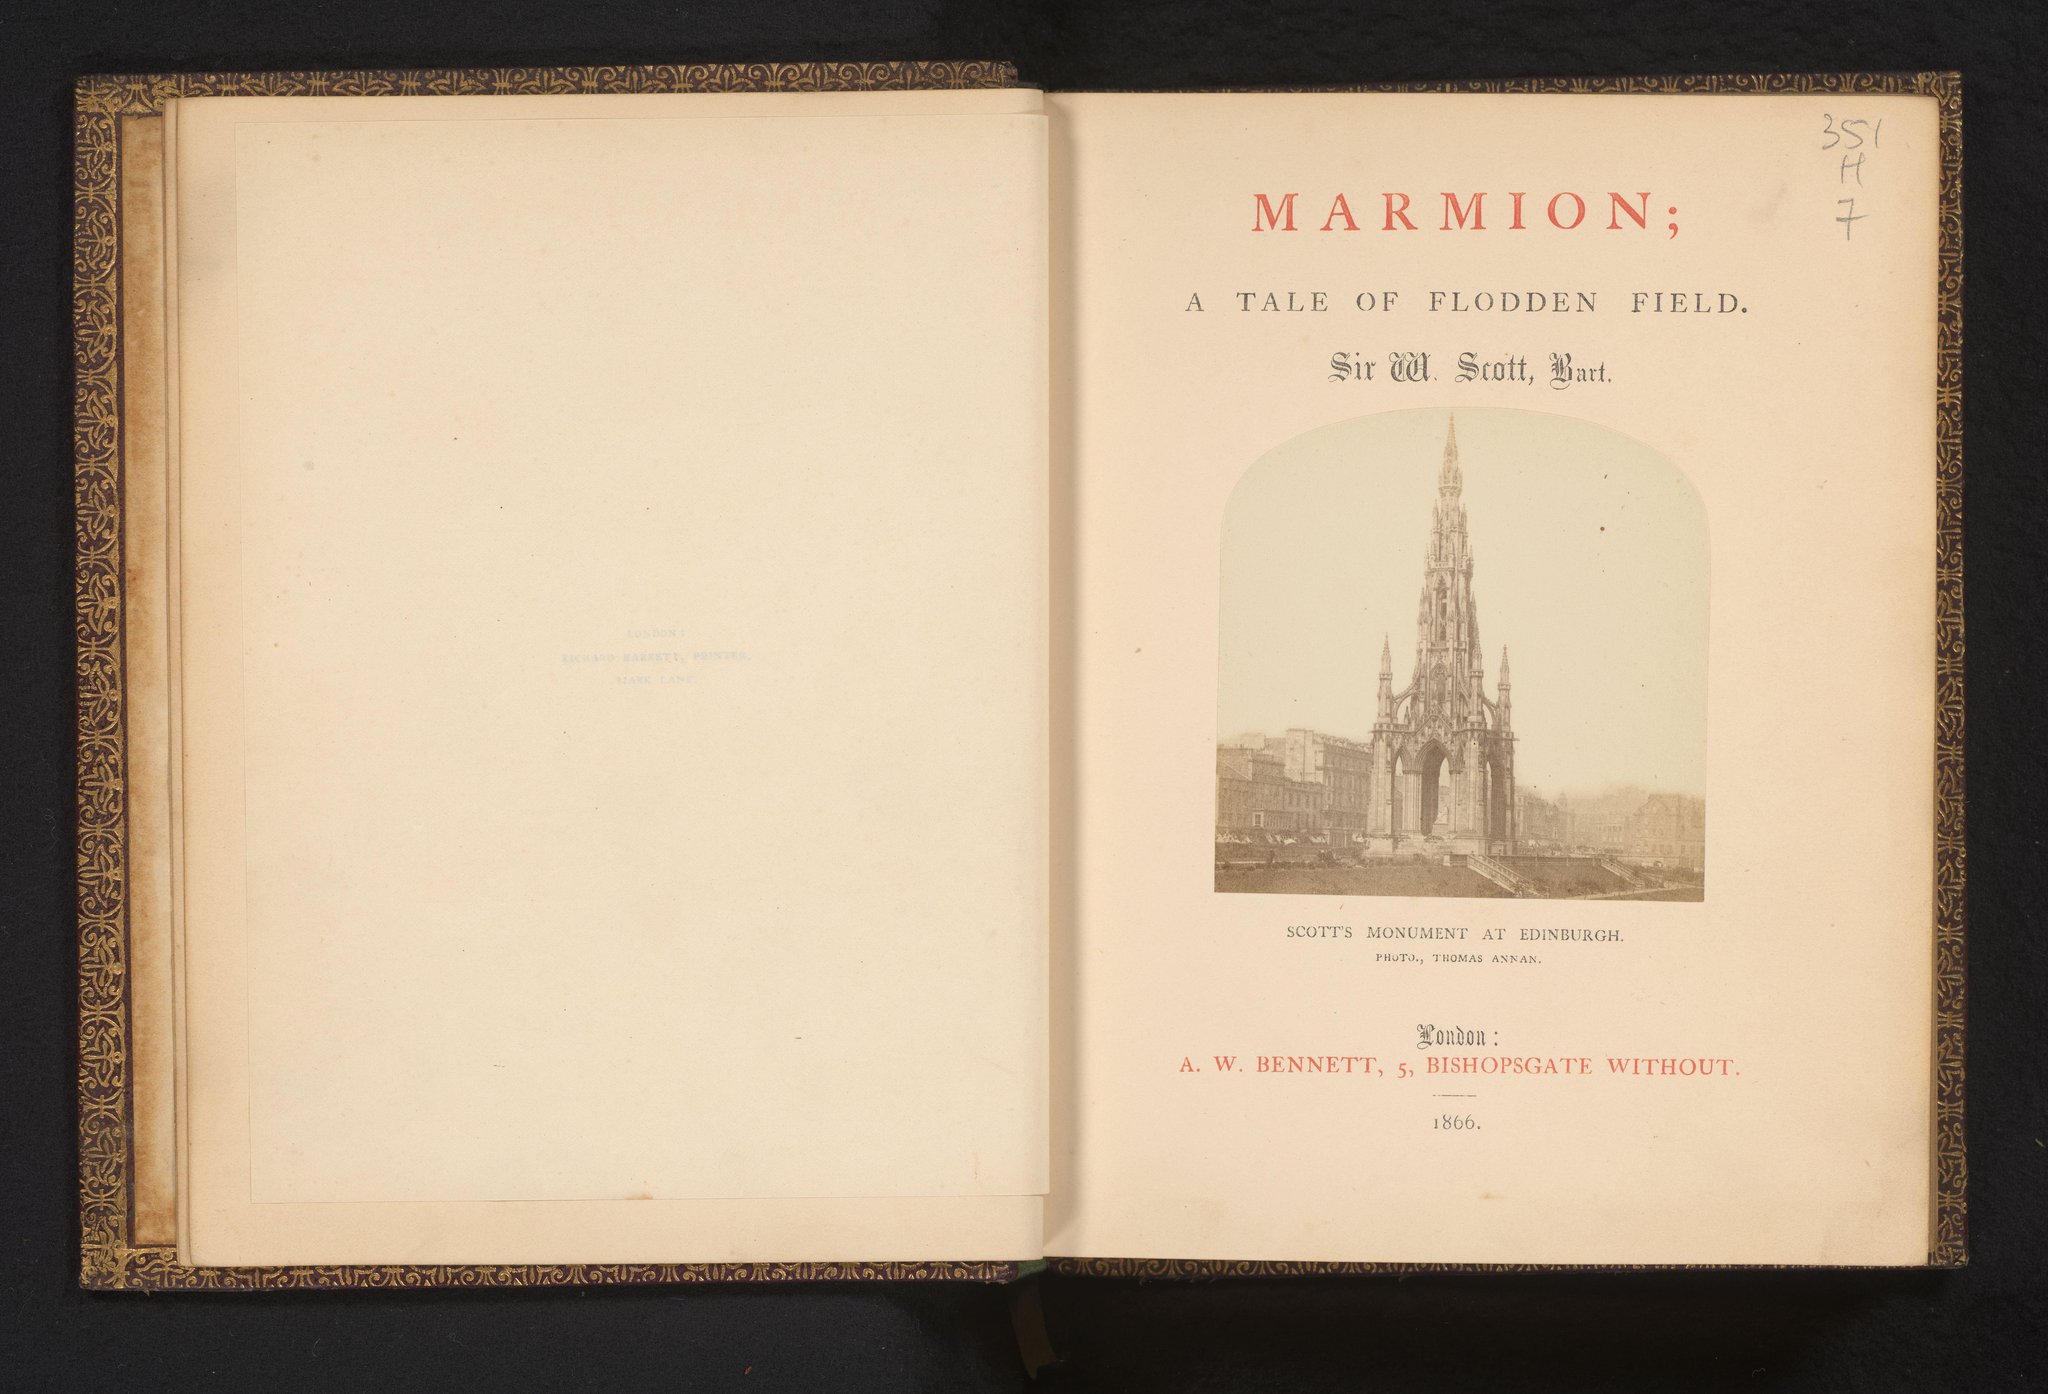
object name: book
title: Marmion; a tale of Flodden Field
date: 1866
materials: paper, cardboard, leather, textile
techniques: albumen print, letterpress printing, engraving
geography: london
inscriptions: inscription: ‘p.22’